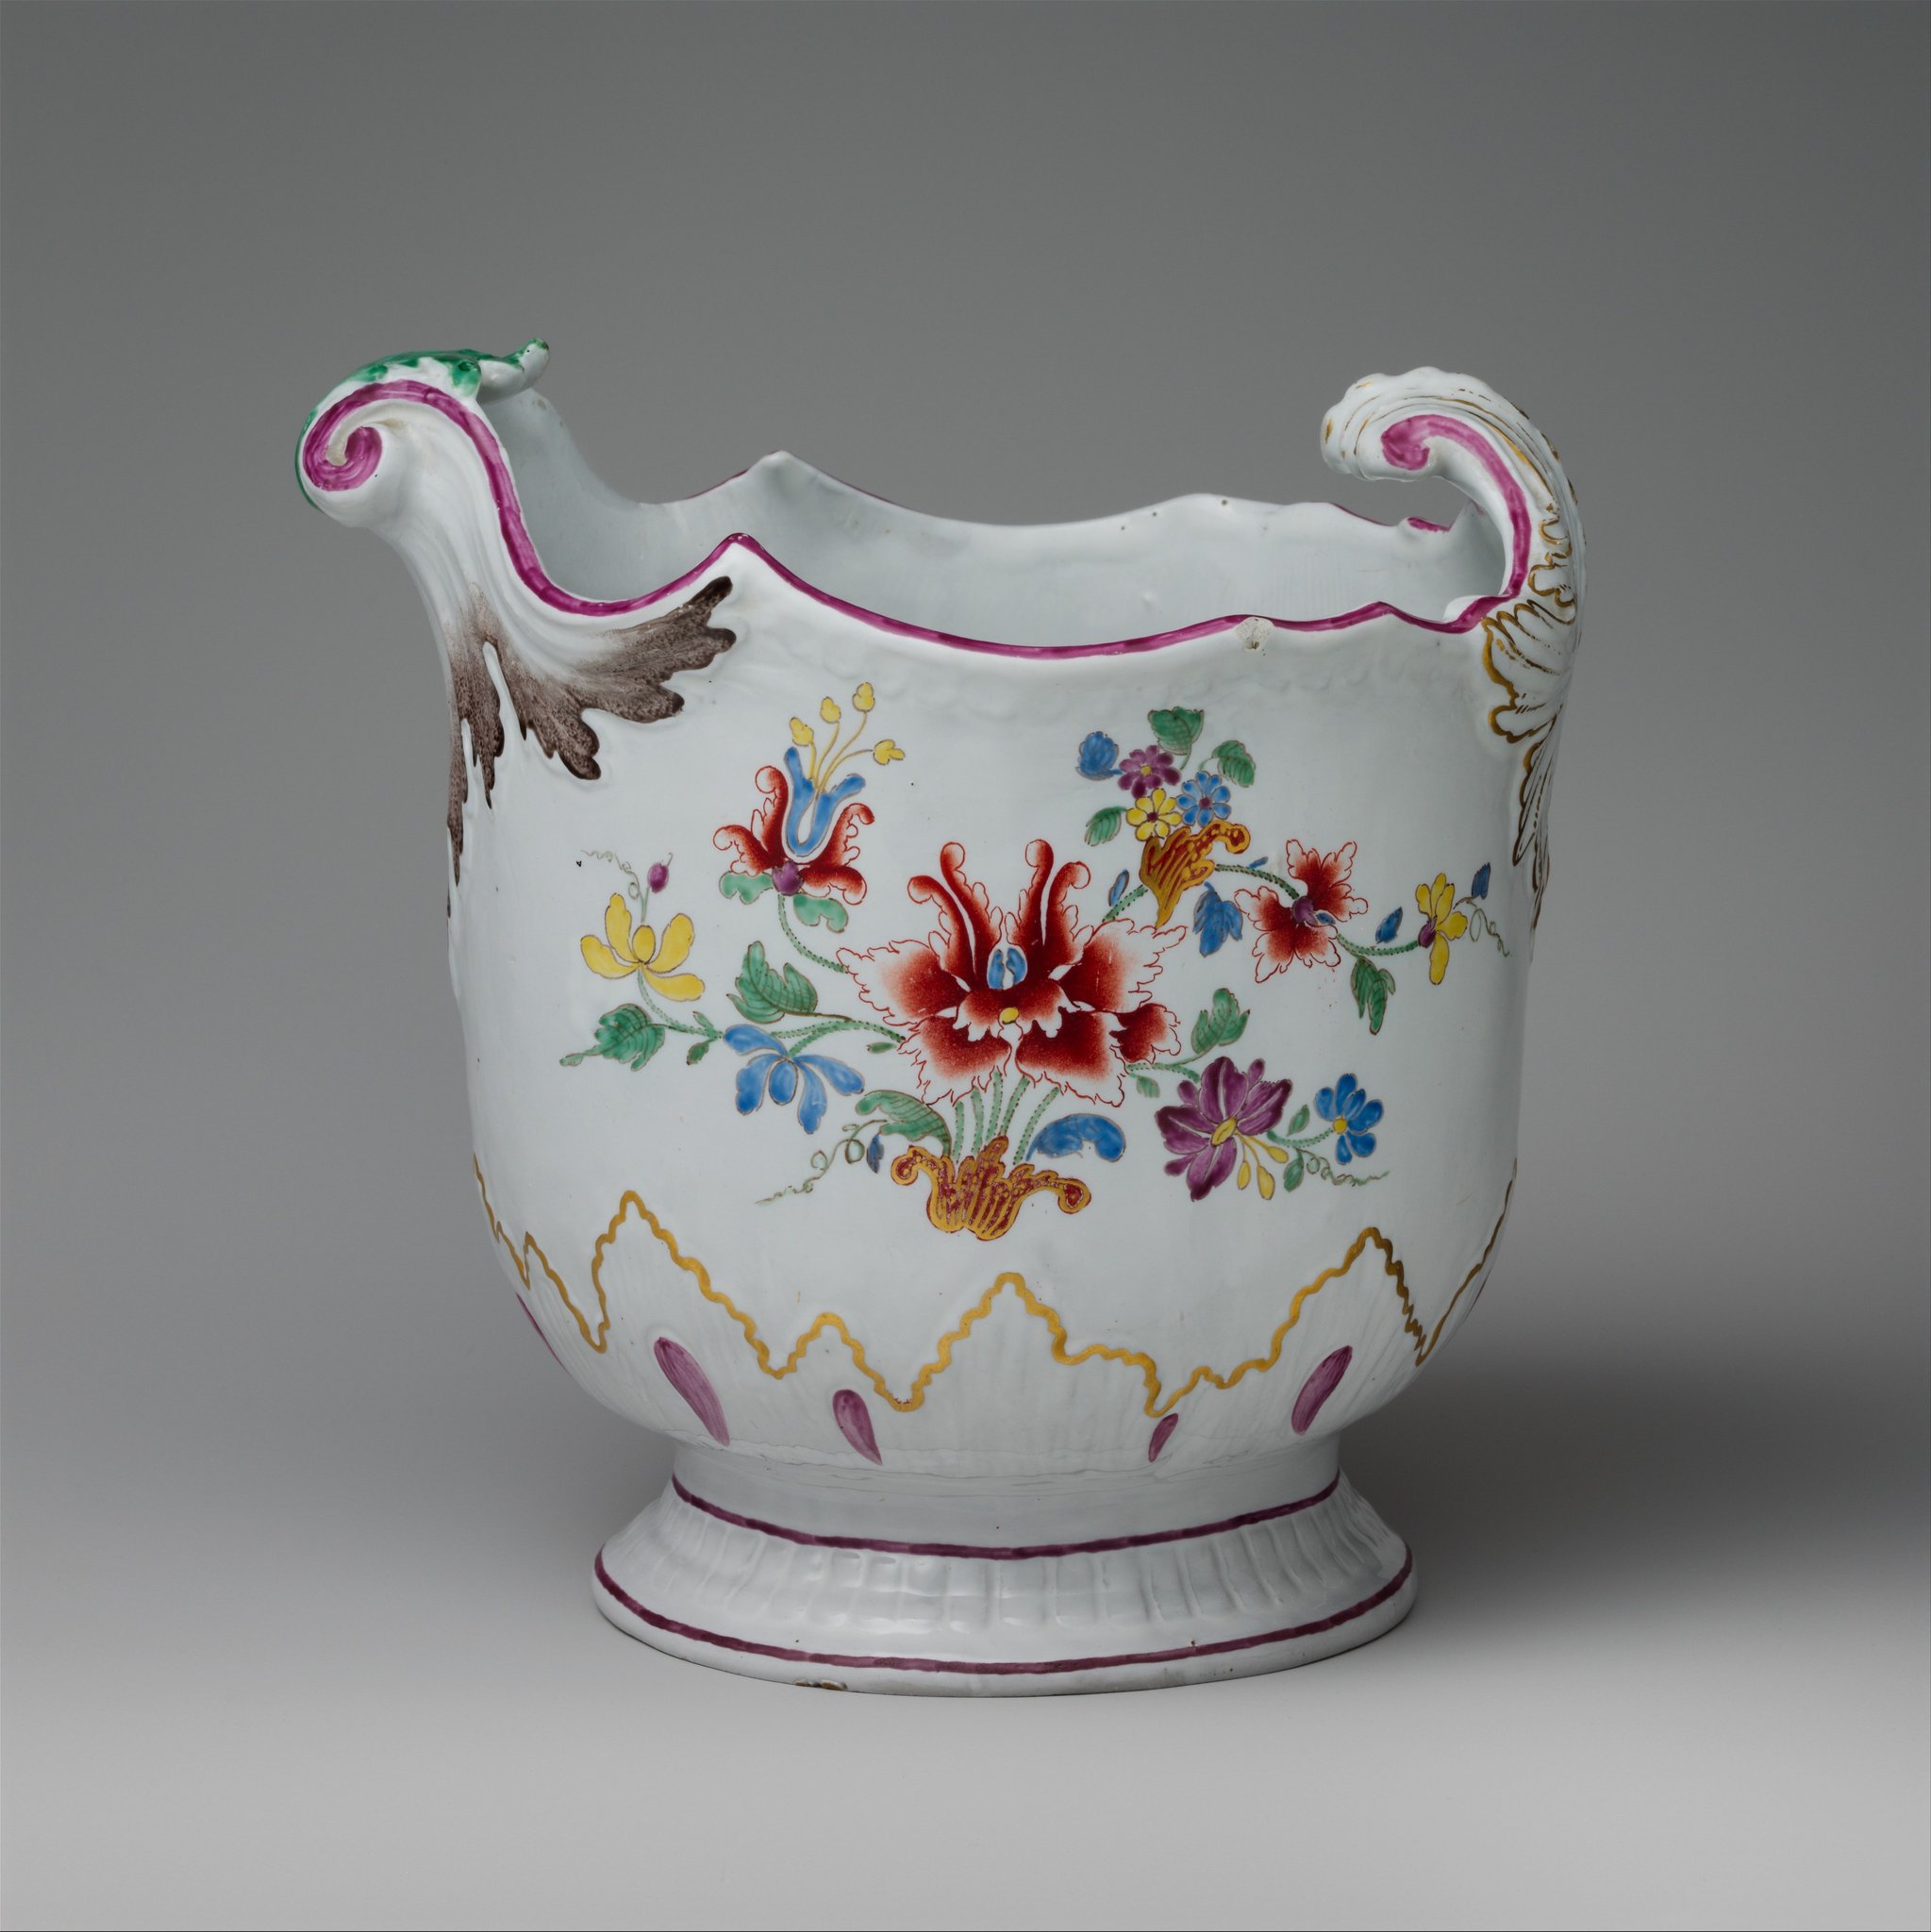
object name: wine cooler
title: Wine bottle cooler (one of a pair)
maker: doccia porcelain manufactory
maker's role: manufactory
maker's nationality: italian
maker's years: 1737-1896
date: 1760-1770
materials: hard paste porcelain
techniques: glazing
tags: flowers